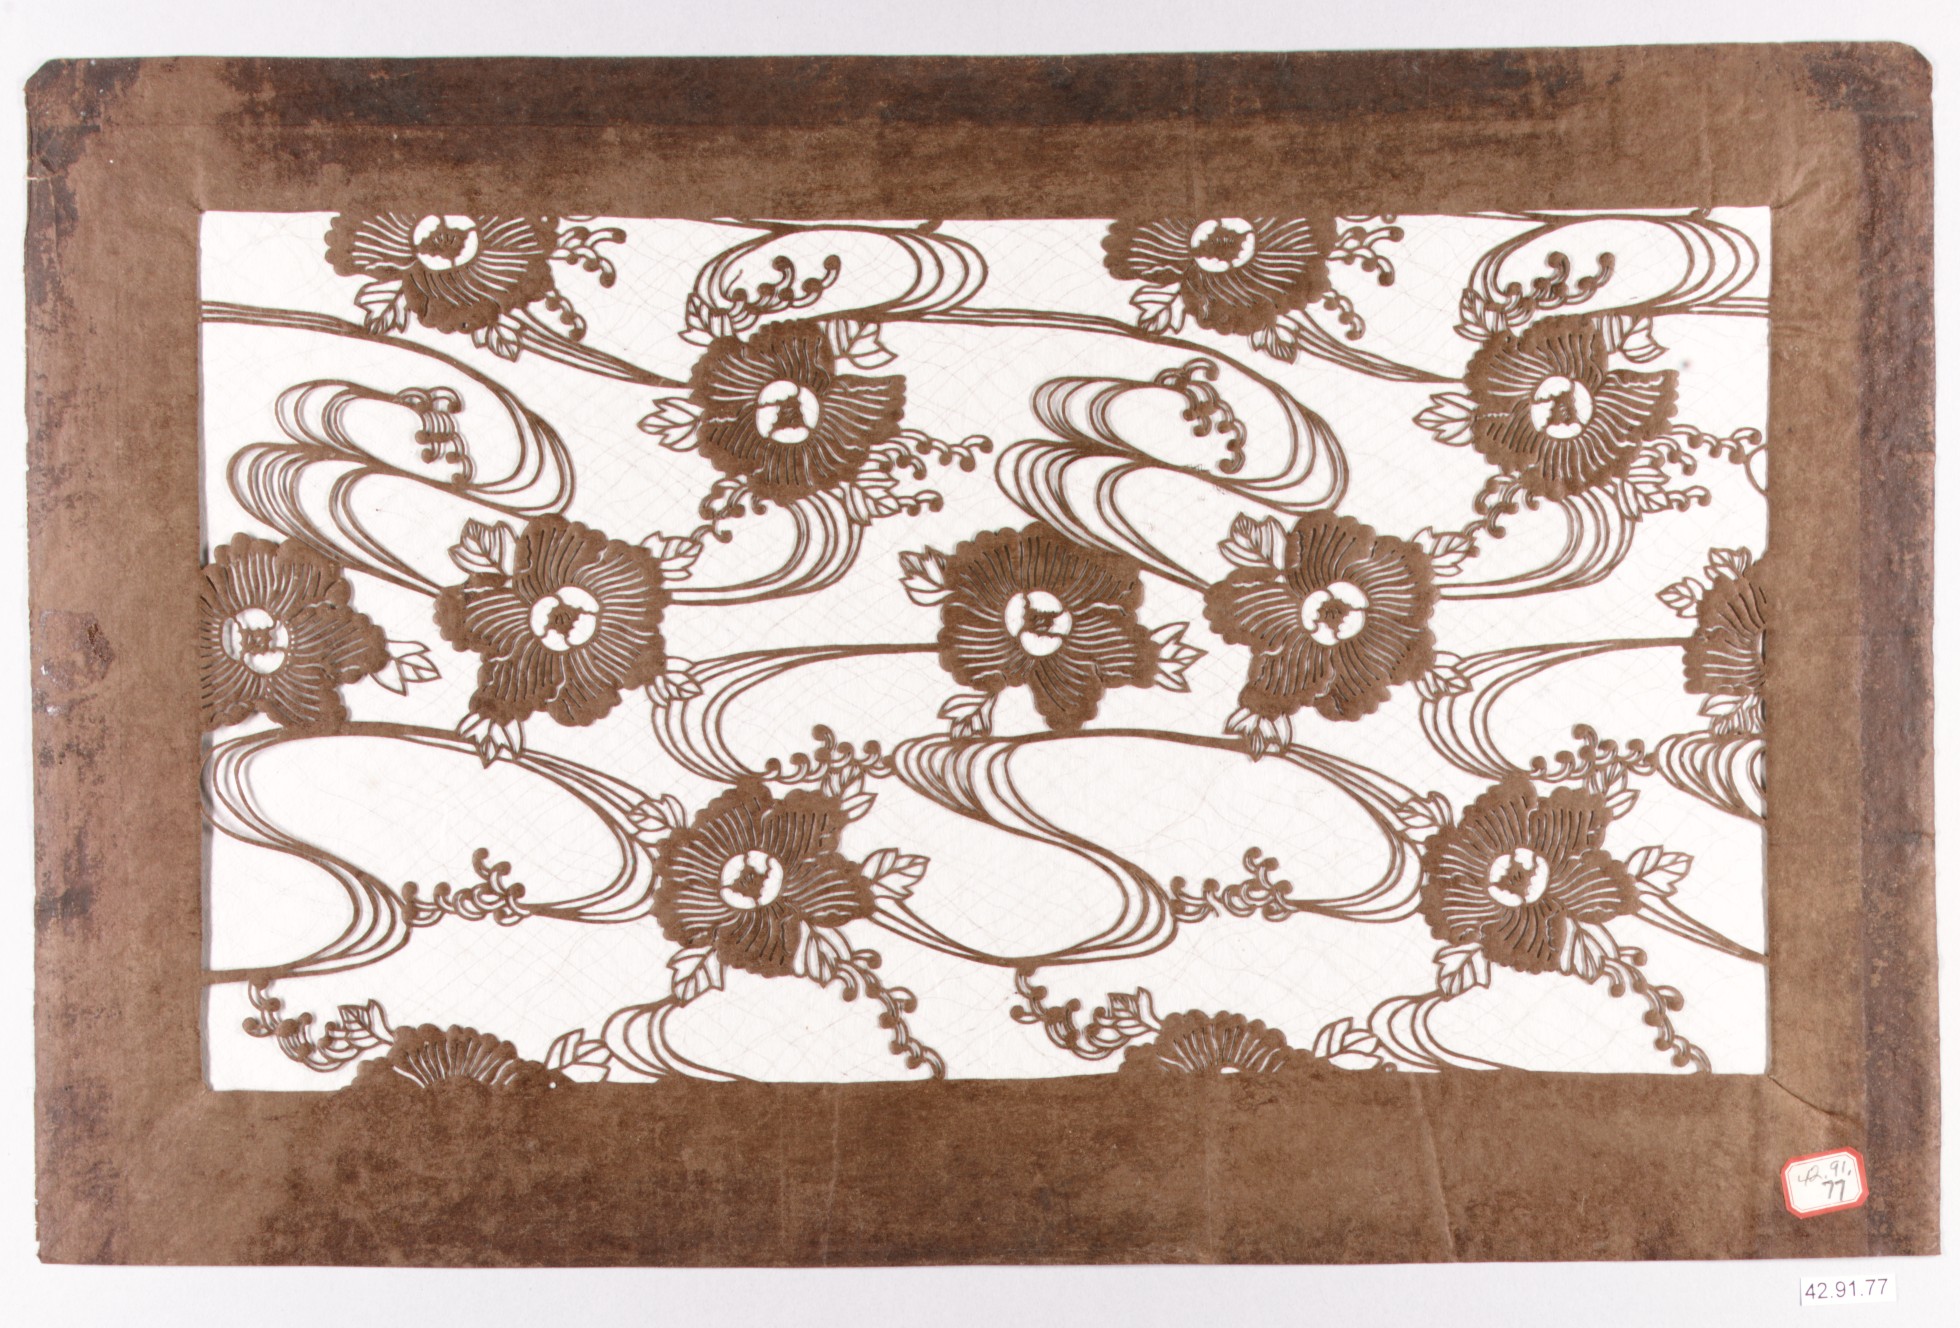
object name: stencil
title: Stencil with Pattern of Open Flowers on Water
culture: japanese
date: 1801-1900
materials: paper, silk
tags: flowers